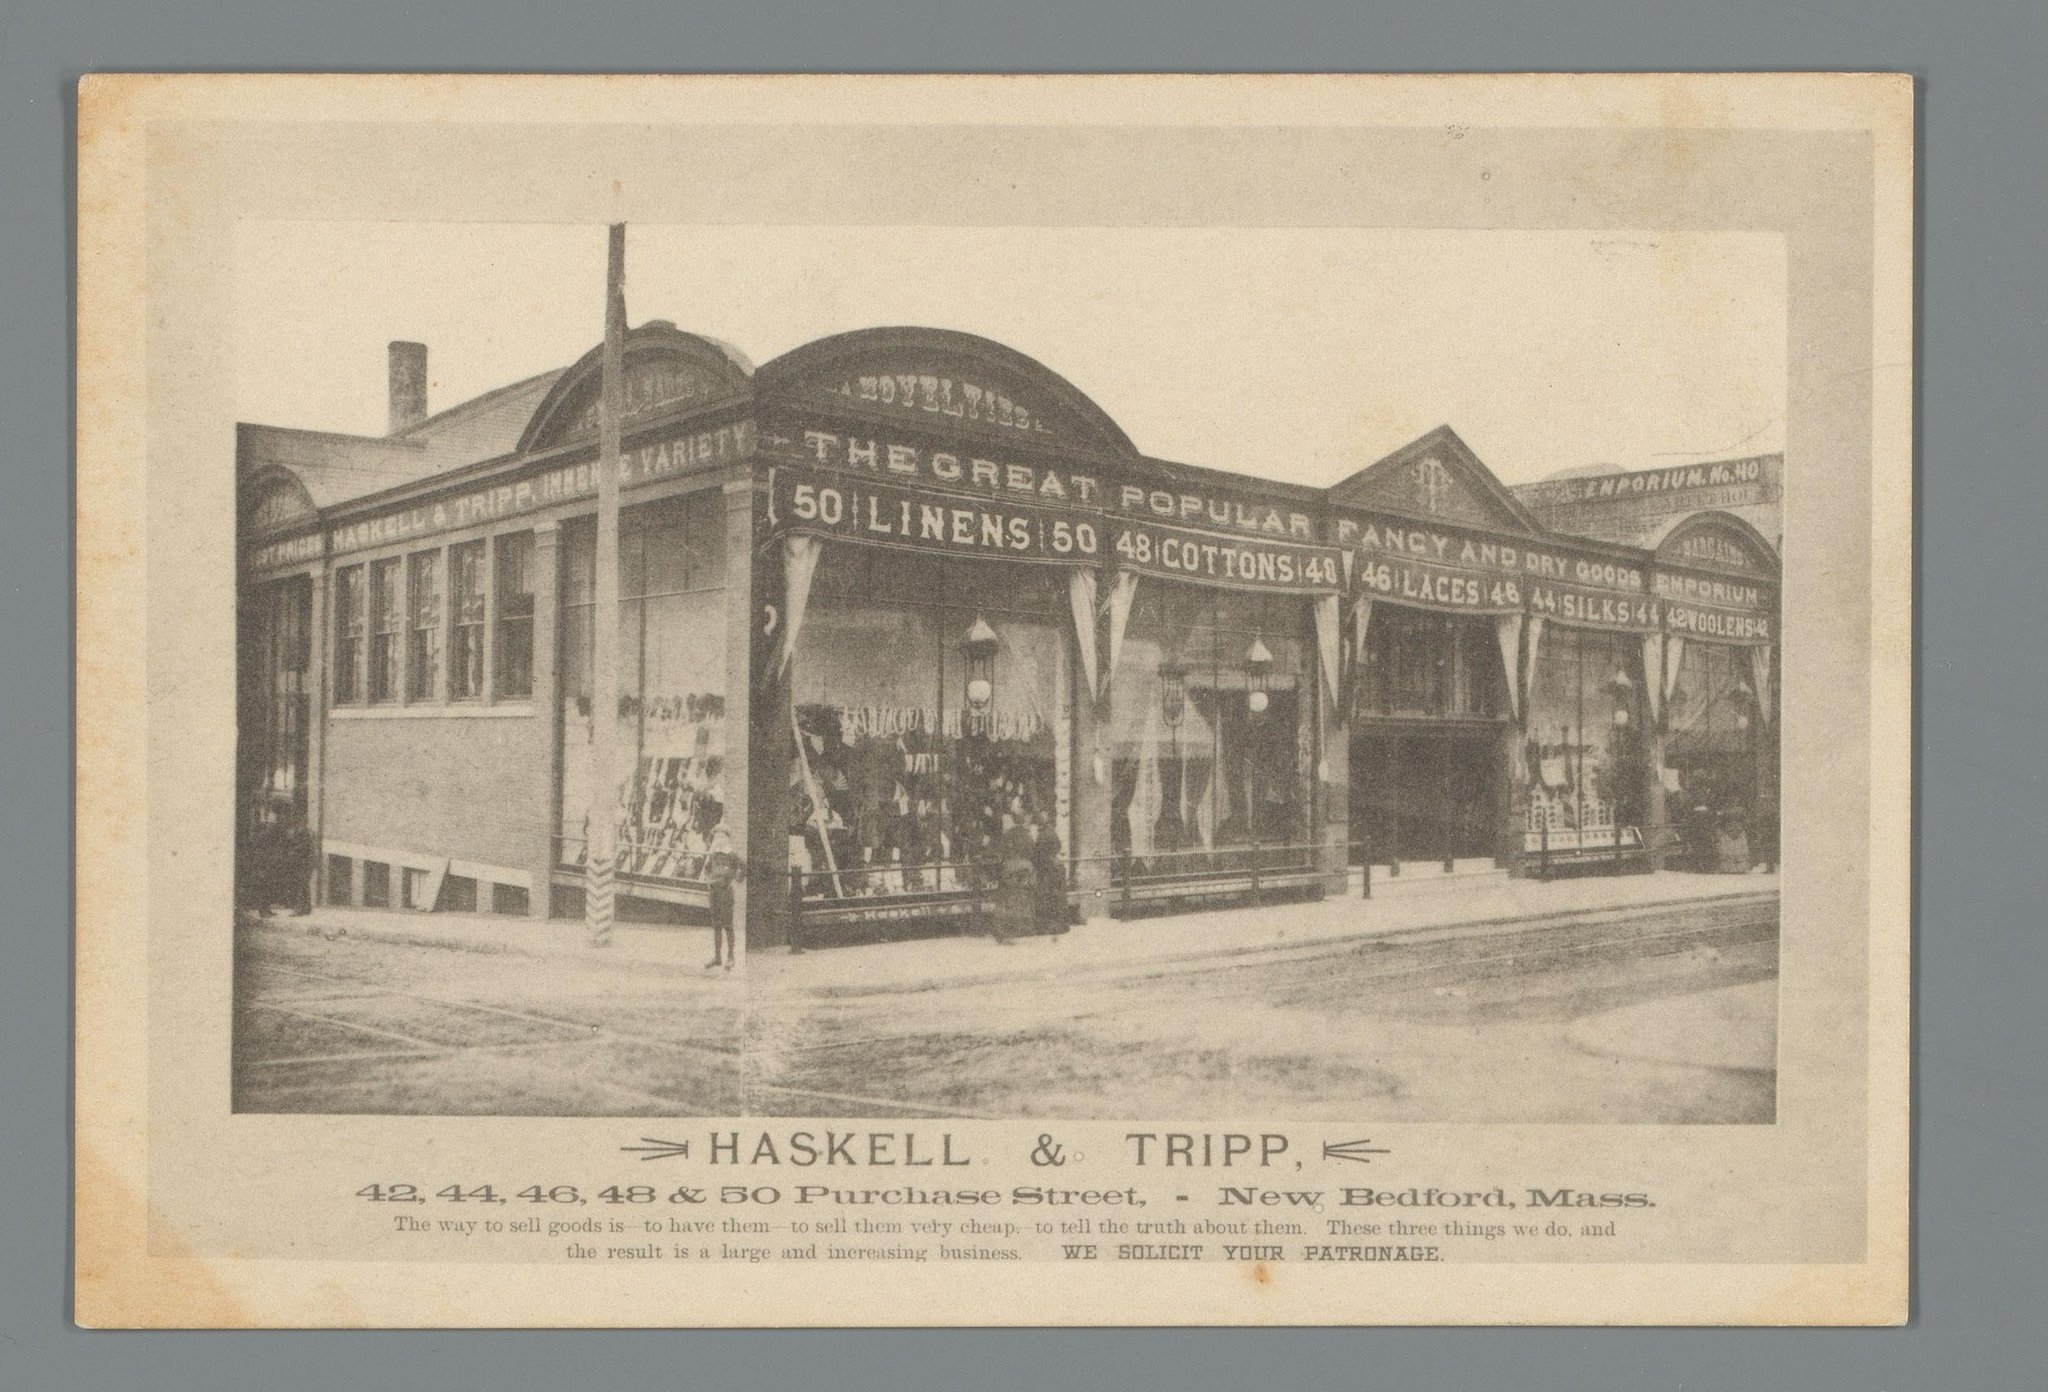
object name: photomechanical print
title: Gezicht op de winkel van Haskell & Tripp in New Bedford, Massachusetts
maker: Anonymous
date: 1880-1905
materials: cardboard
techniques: photoaquatint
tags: shop, store, advertising